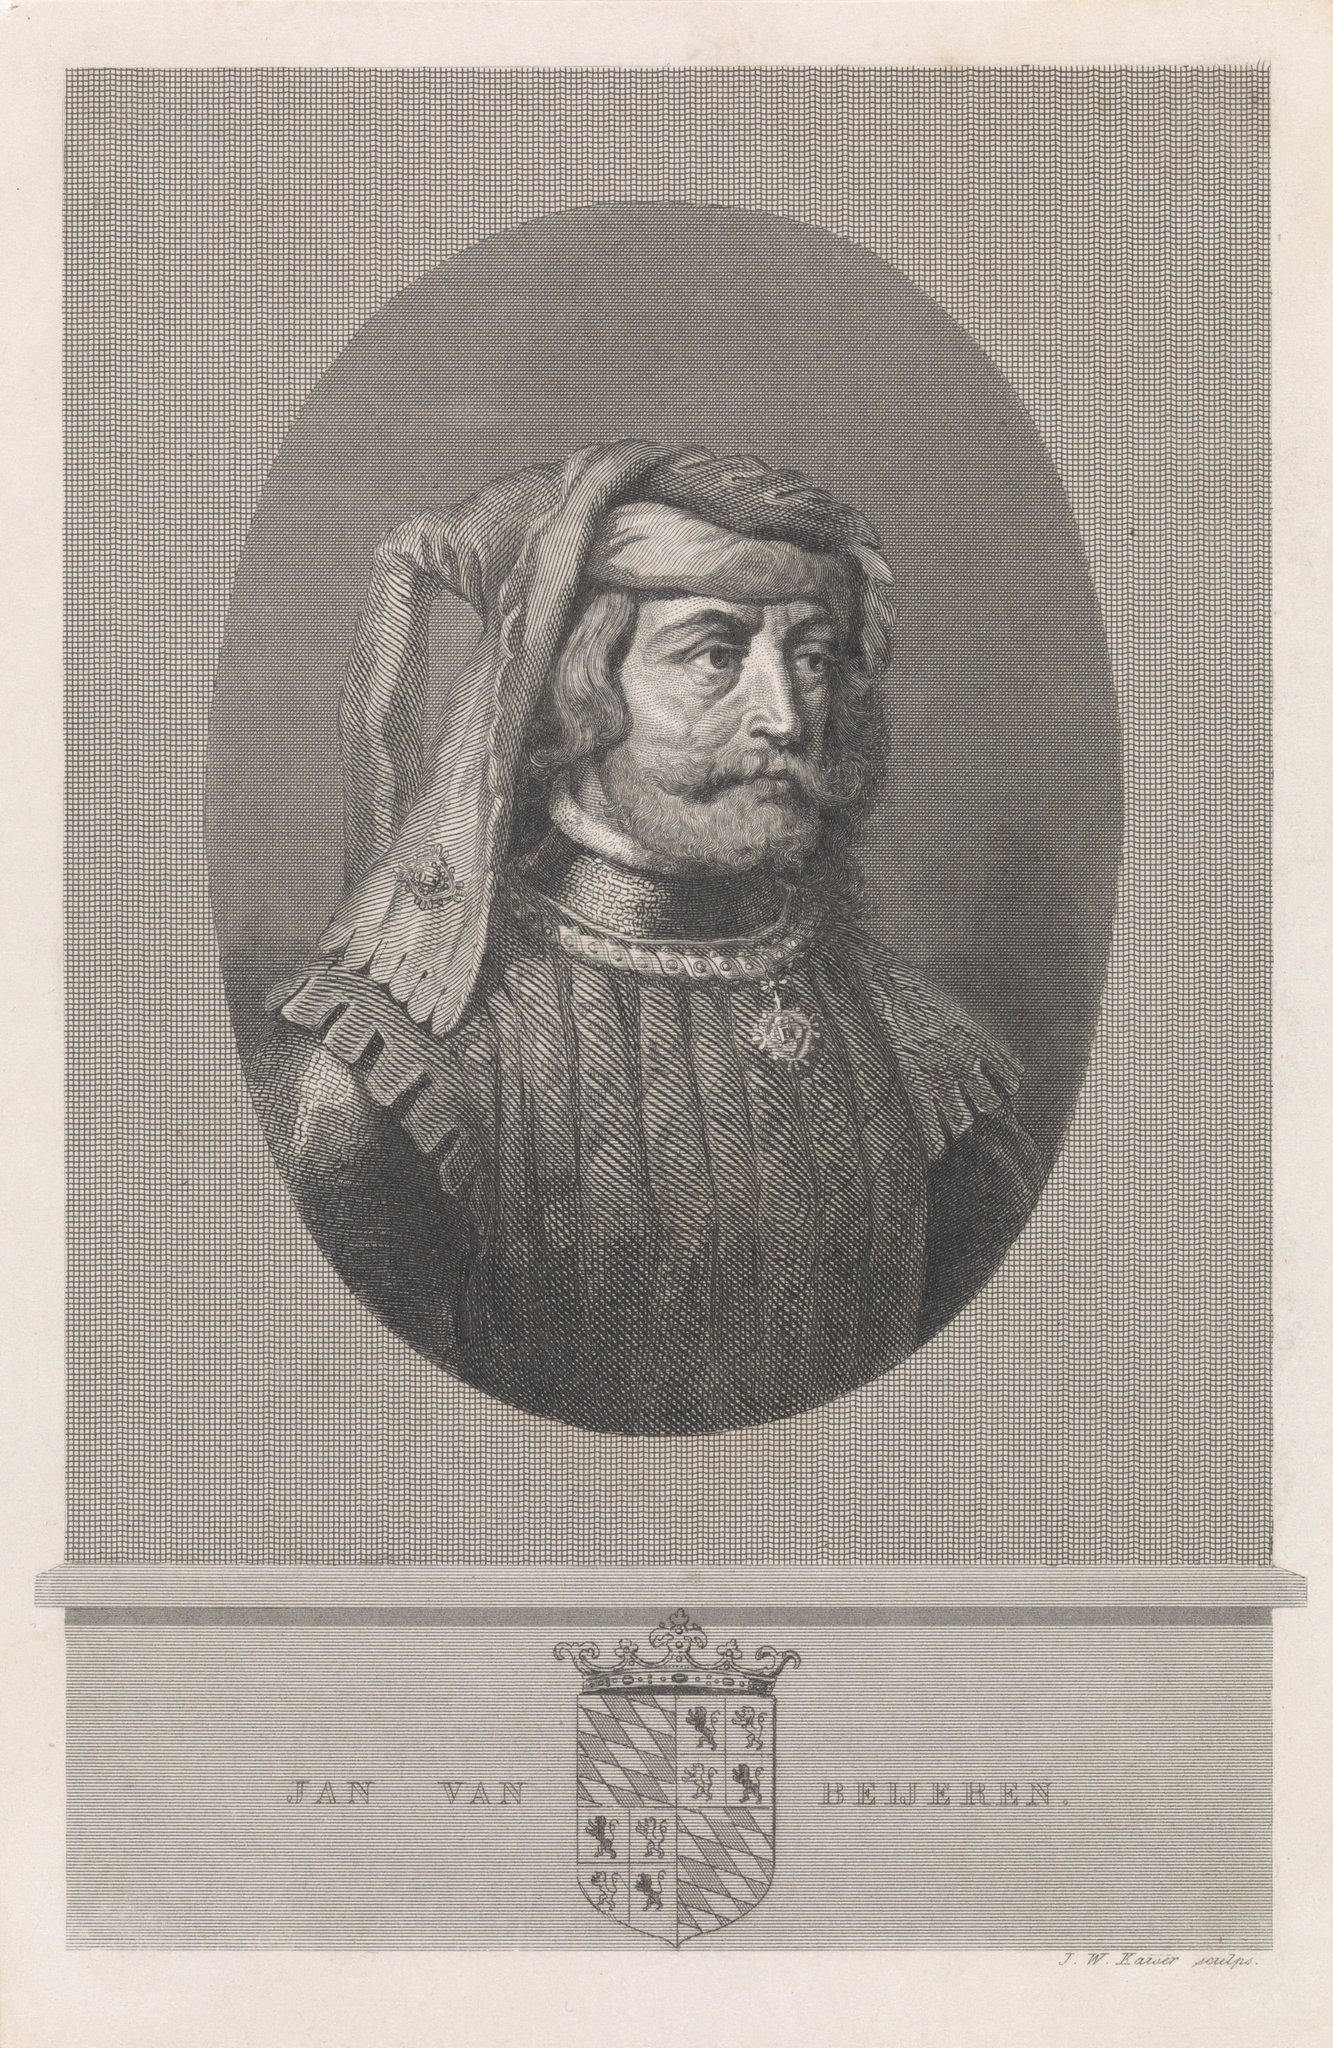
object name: print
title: Portret van Jan van Beieren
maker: johann wilhelm kaiser (i)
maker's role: draughtsman, print maker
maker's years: 1813-1900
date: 1840-1884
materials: paper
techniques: engraving, etching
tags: jan van beieren, adult man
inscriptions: collector's mark: Lugt 2228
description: Portretbuste van Jan van Beieren naar rechts, in een ovale lijst. Hij heeft een snor en een bescheiden baard. Hij draagt een muts met orgelpijpplooien. In de marge zijn familiewapen